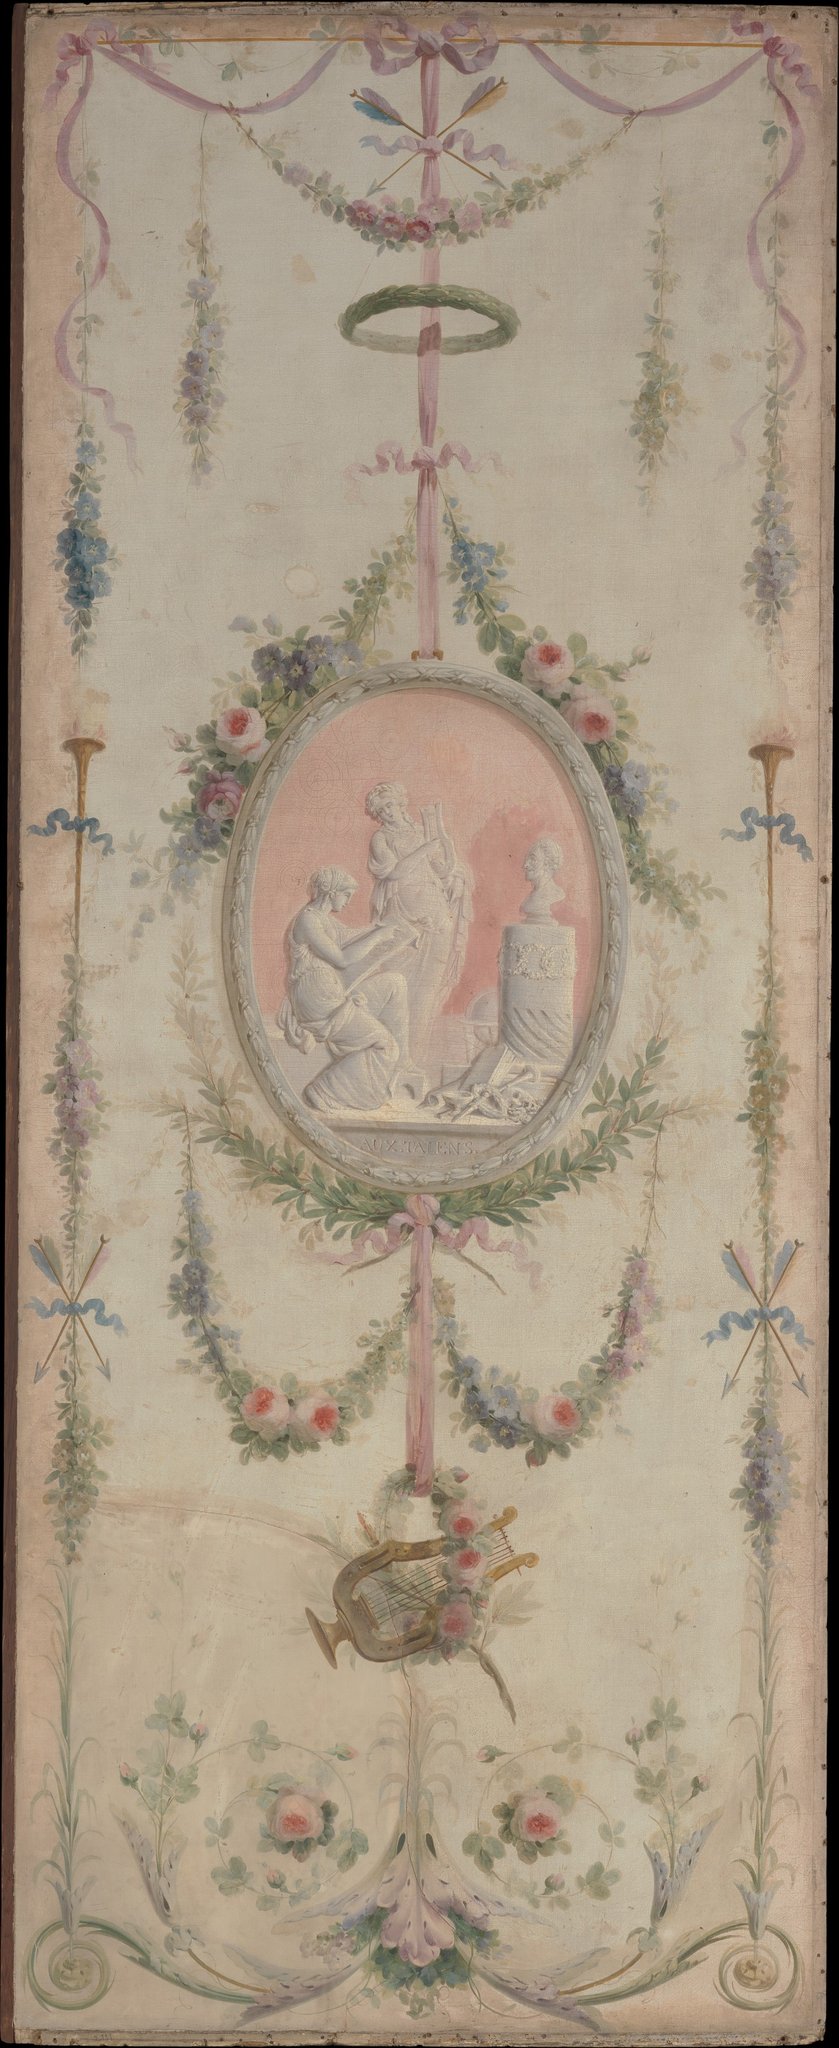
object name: decorative panel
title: Allegory of the Arts (one of a pair)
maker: le riche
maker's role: artist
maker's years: 1750-1810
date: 1701-1800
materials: canvas, oil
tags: human figures,wreaths